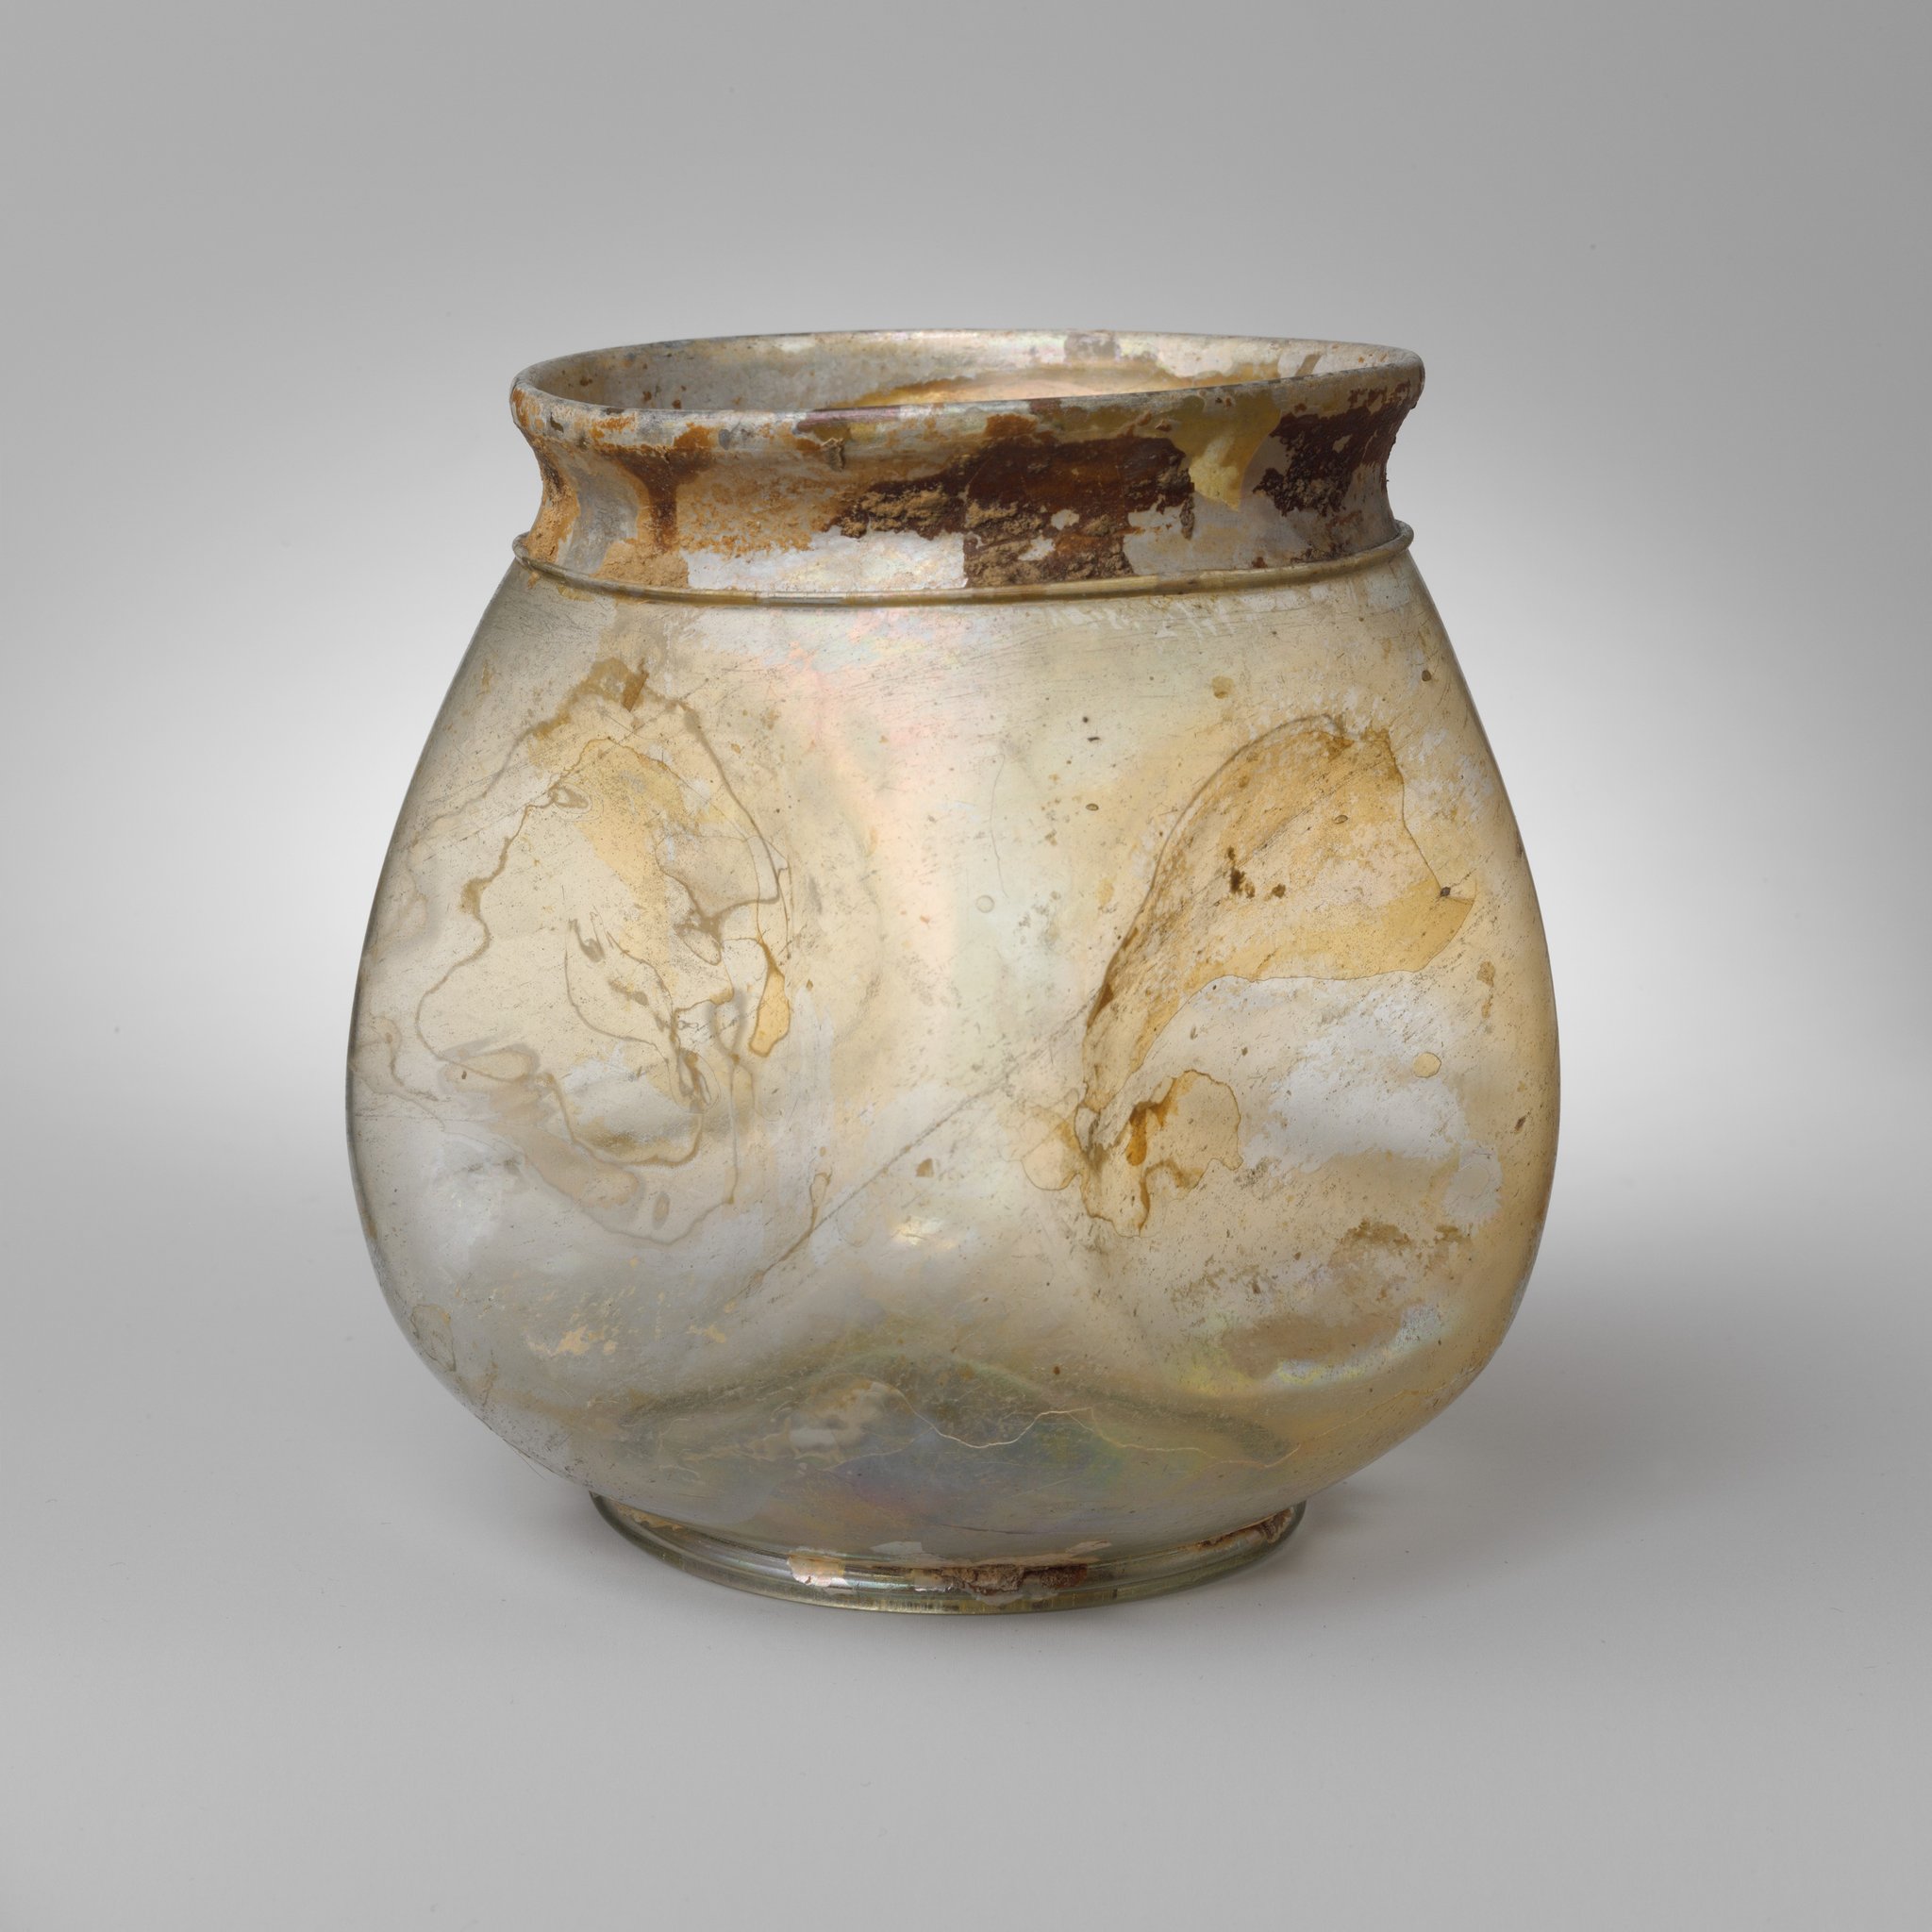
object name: beaker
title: Glass beaker with indented sides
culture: roman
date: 134-233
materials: glass